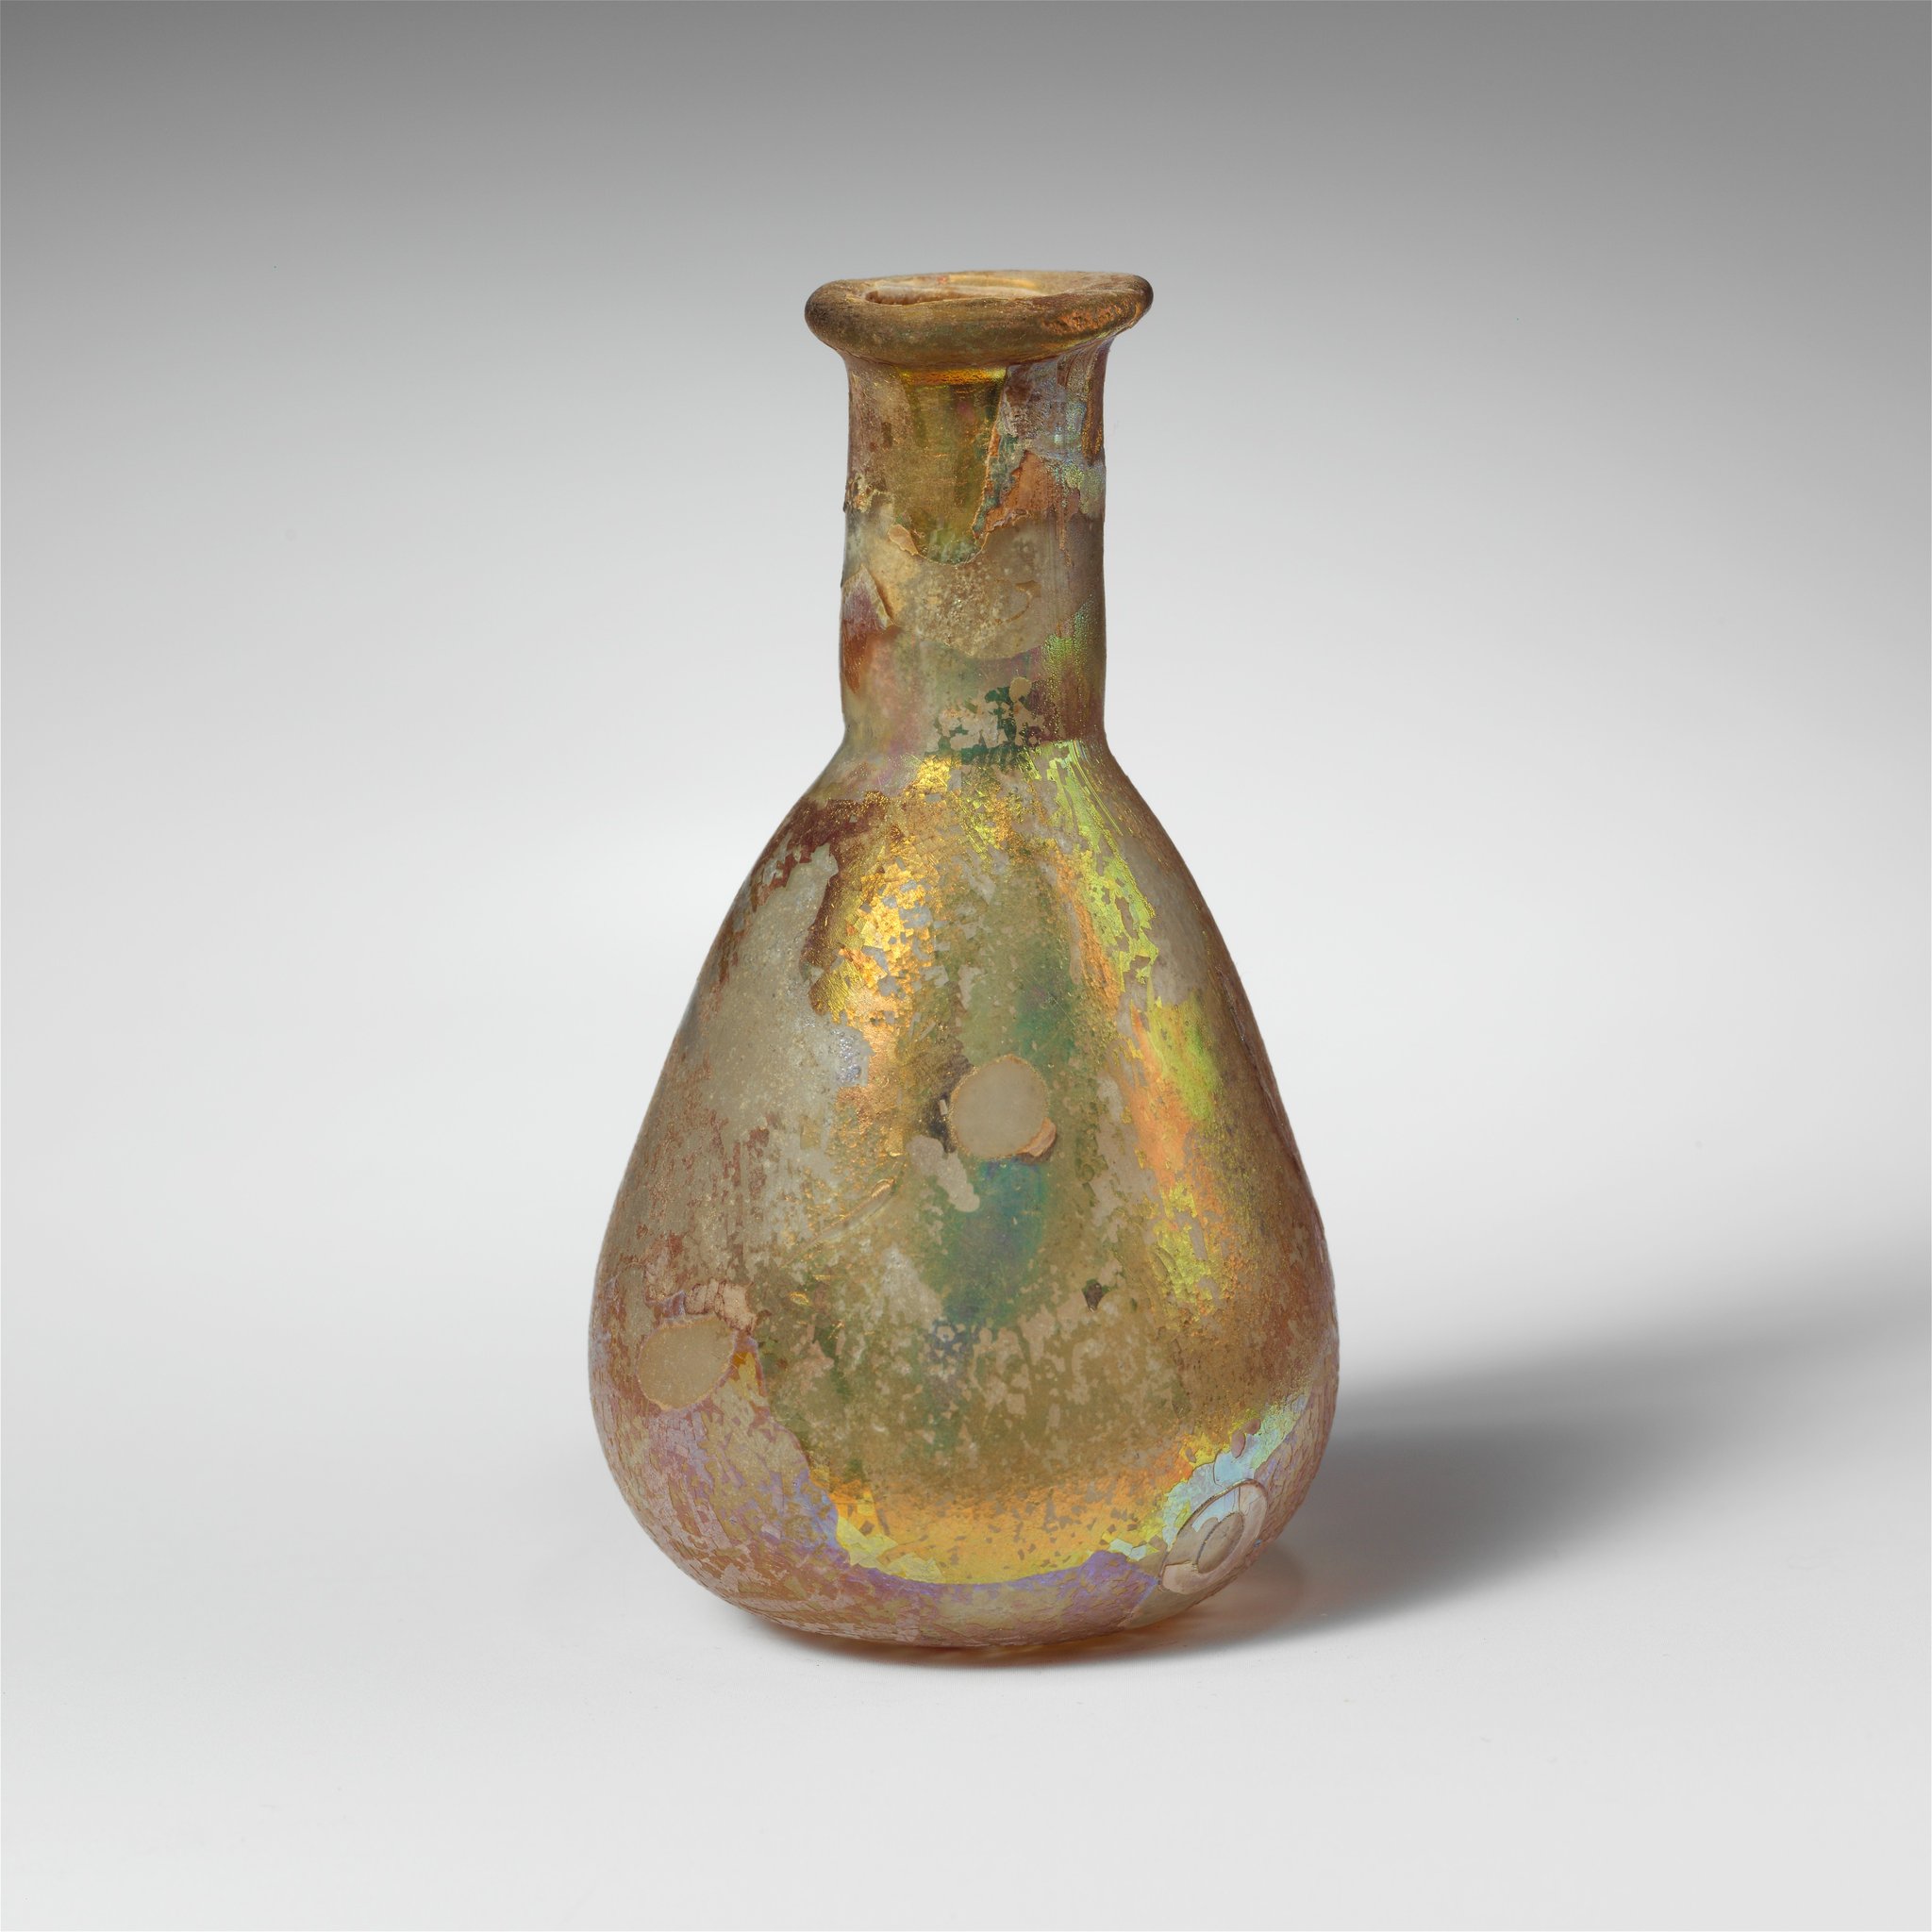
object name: perfume bottle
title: Glass perfume bottle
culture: roman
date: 1-100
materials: glass